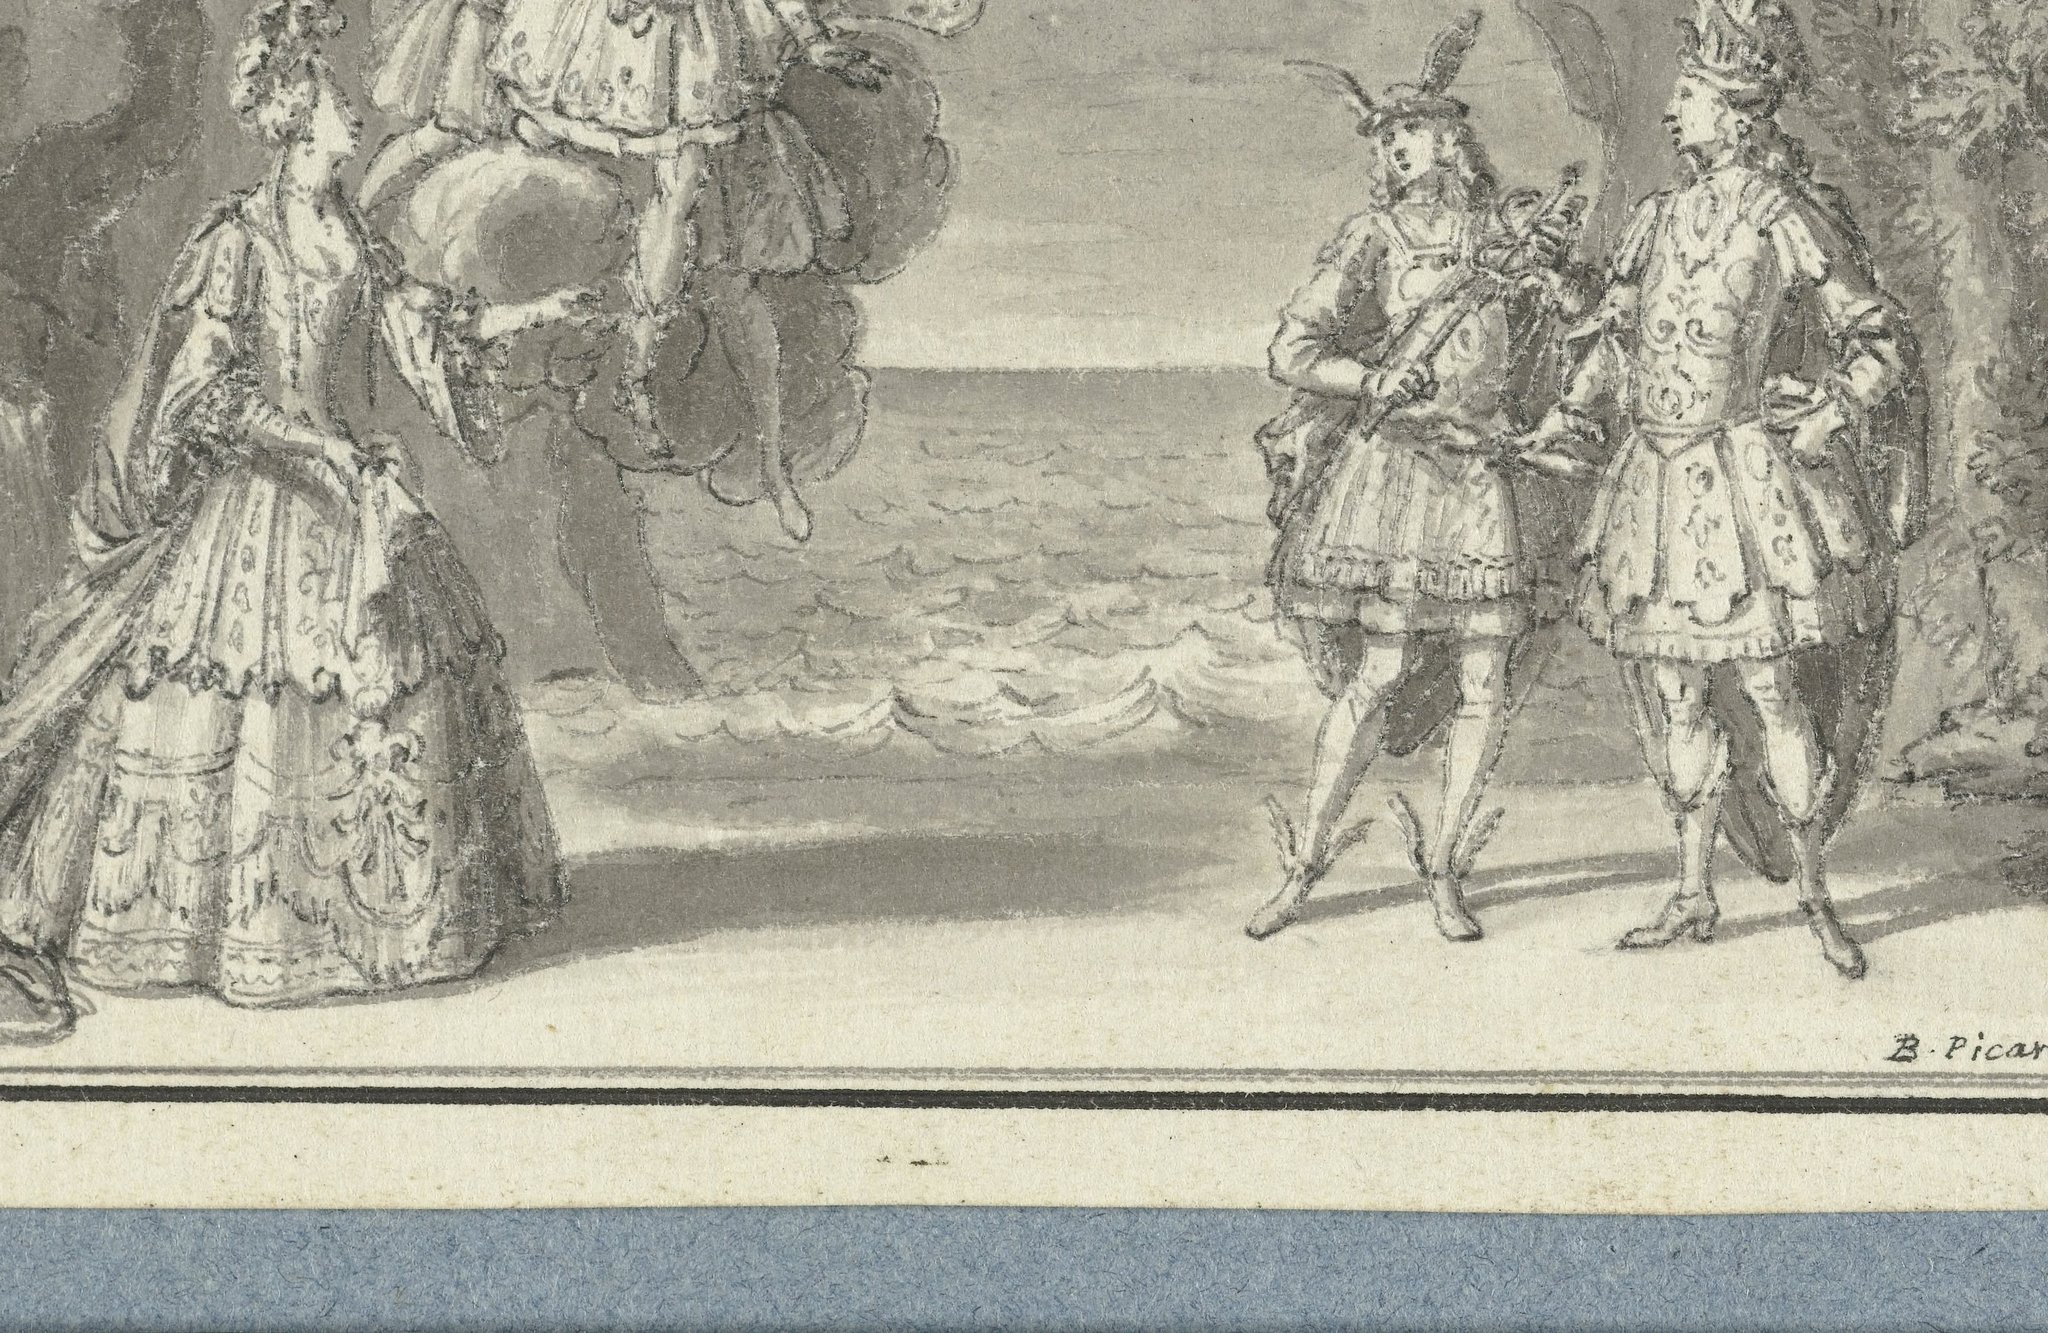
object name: drawing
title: Scène uit de tragedie van Thetis en Peleus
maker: bernard picart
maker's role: draughtsman, print maker, publisher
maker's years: 1673-1733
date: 1728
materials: ink, paper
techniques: brush, pen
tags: group of actors, troupe; actors on the stage, (story of) peleus and thetis